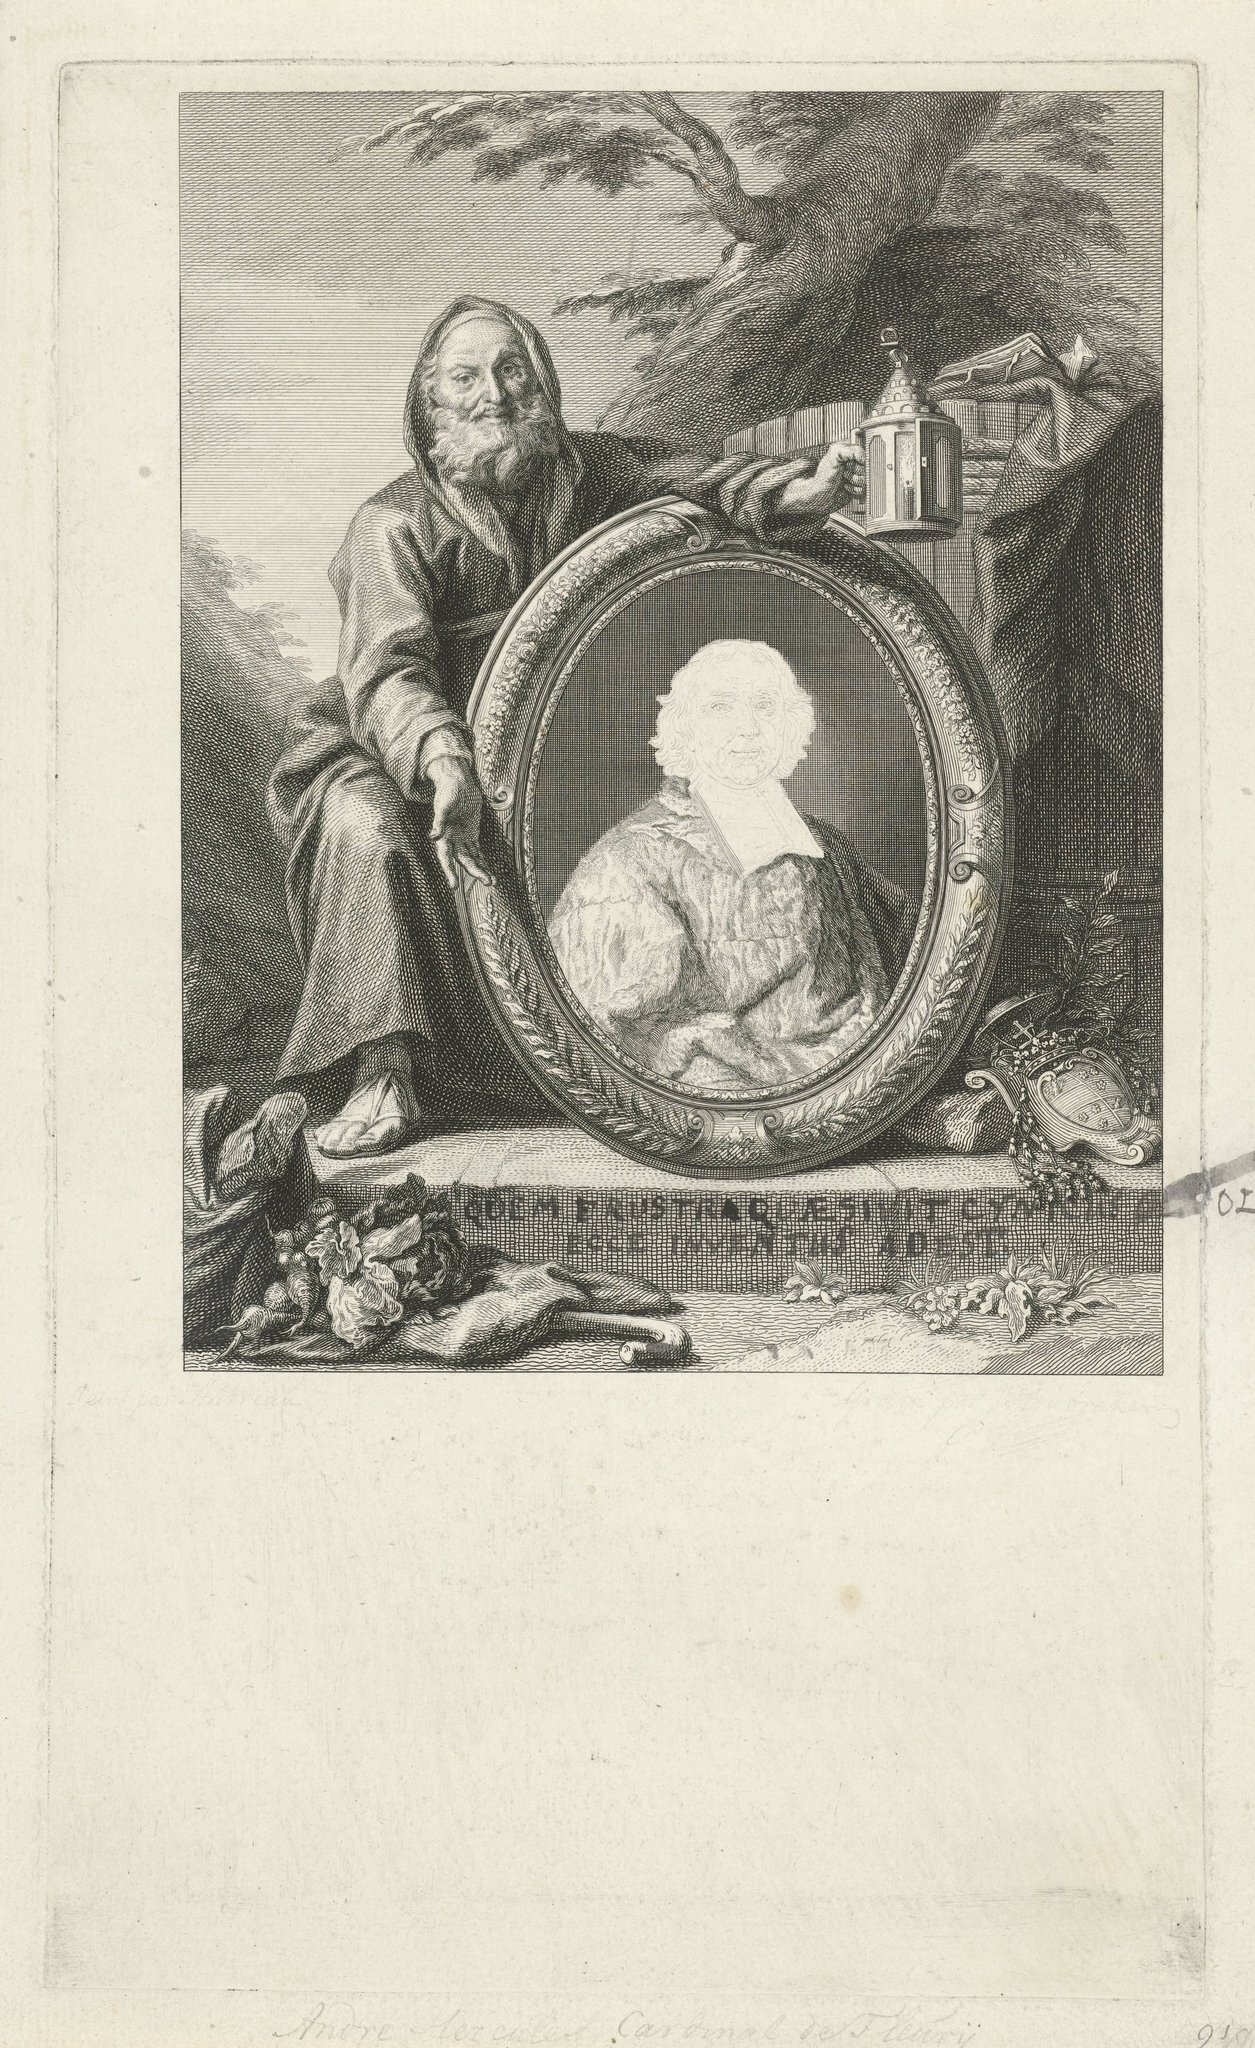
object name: print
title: Diogenes bij een portret van André-Hercule de Fleury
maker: jacob houbraken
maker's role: draughtsman, print maker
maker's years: 1698-1780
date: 1708-1780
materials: paper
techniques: brush, engraving, etching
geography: amsterdam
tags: france, (story of) diogenes, the philosopher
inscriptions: inscription: ‘quem frustrs quaesivit cynicus olim/ ecce inventus ad est’, collector's mark: Lugt 240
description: Een knielende Diogenes, met in zijn hand een lantaarn en op de achtergrond zijn ton, bij een onvoltooid portret van André-Hercule de Fleury in een ovaal ornamenteel medaillon. Links op de voorgrond groenten en op de achtergrond een boom. Midden onder handgeschreven twee regels in het Latijn.